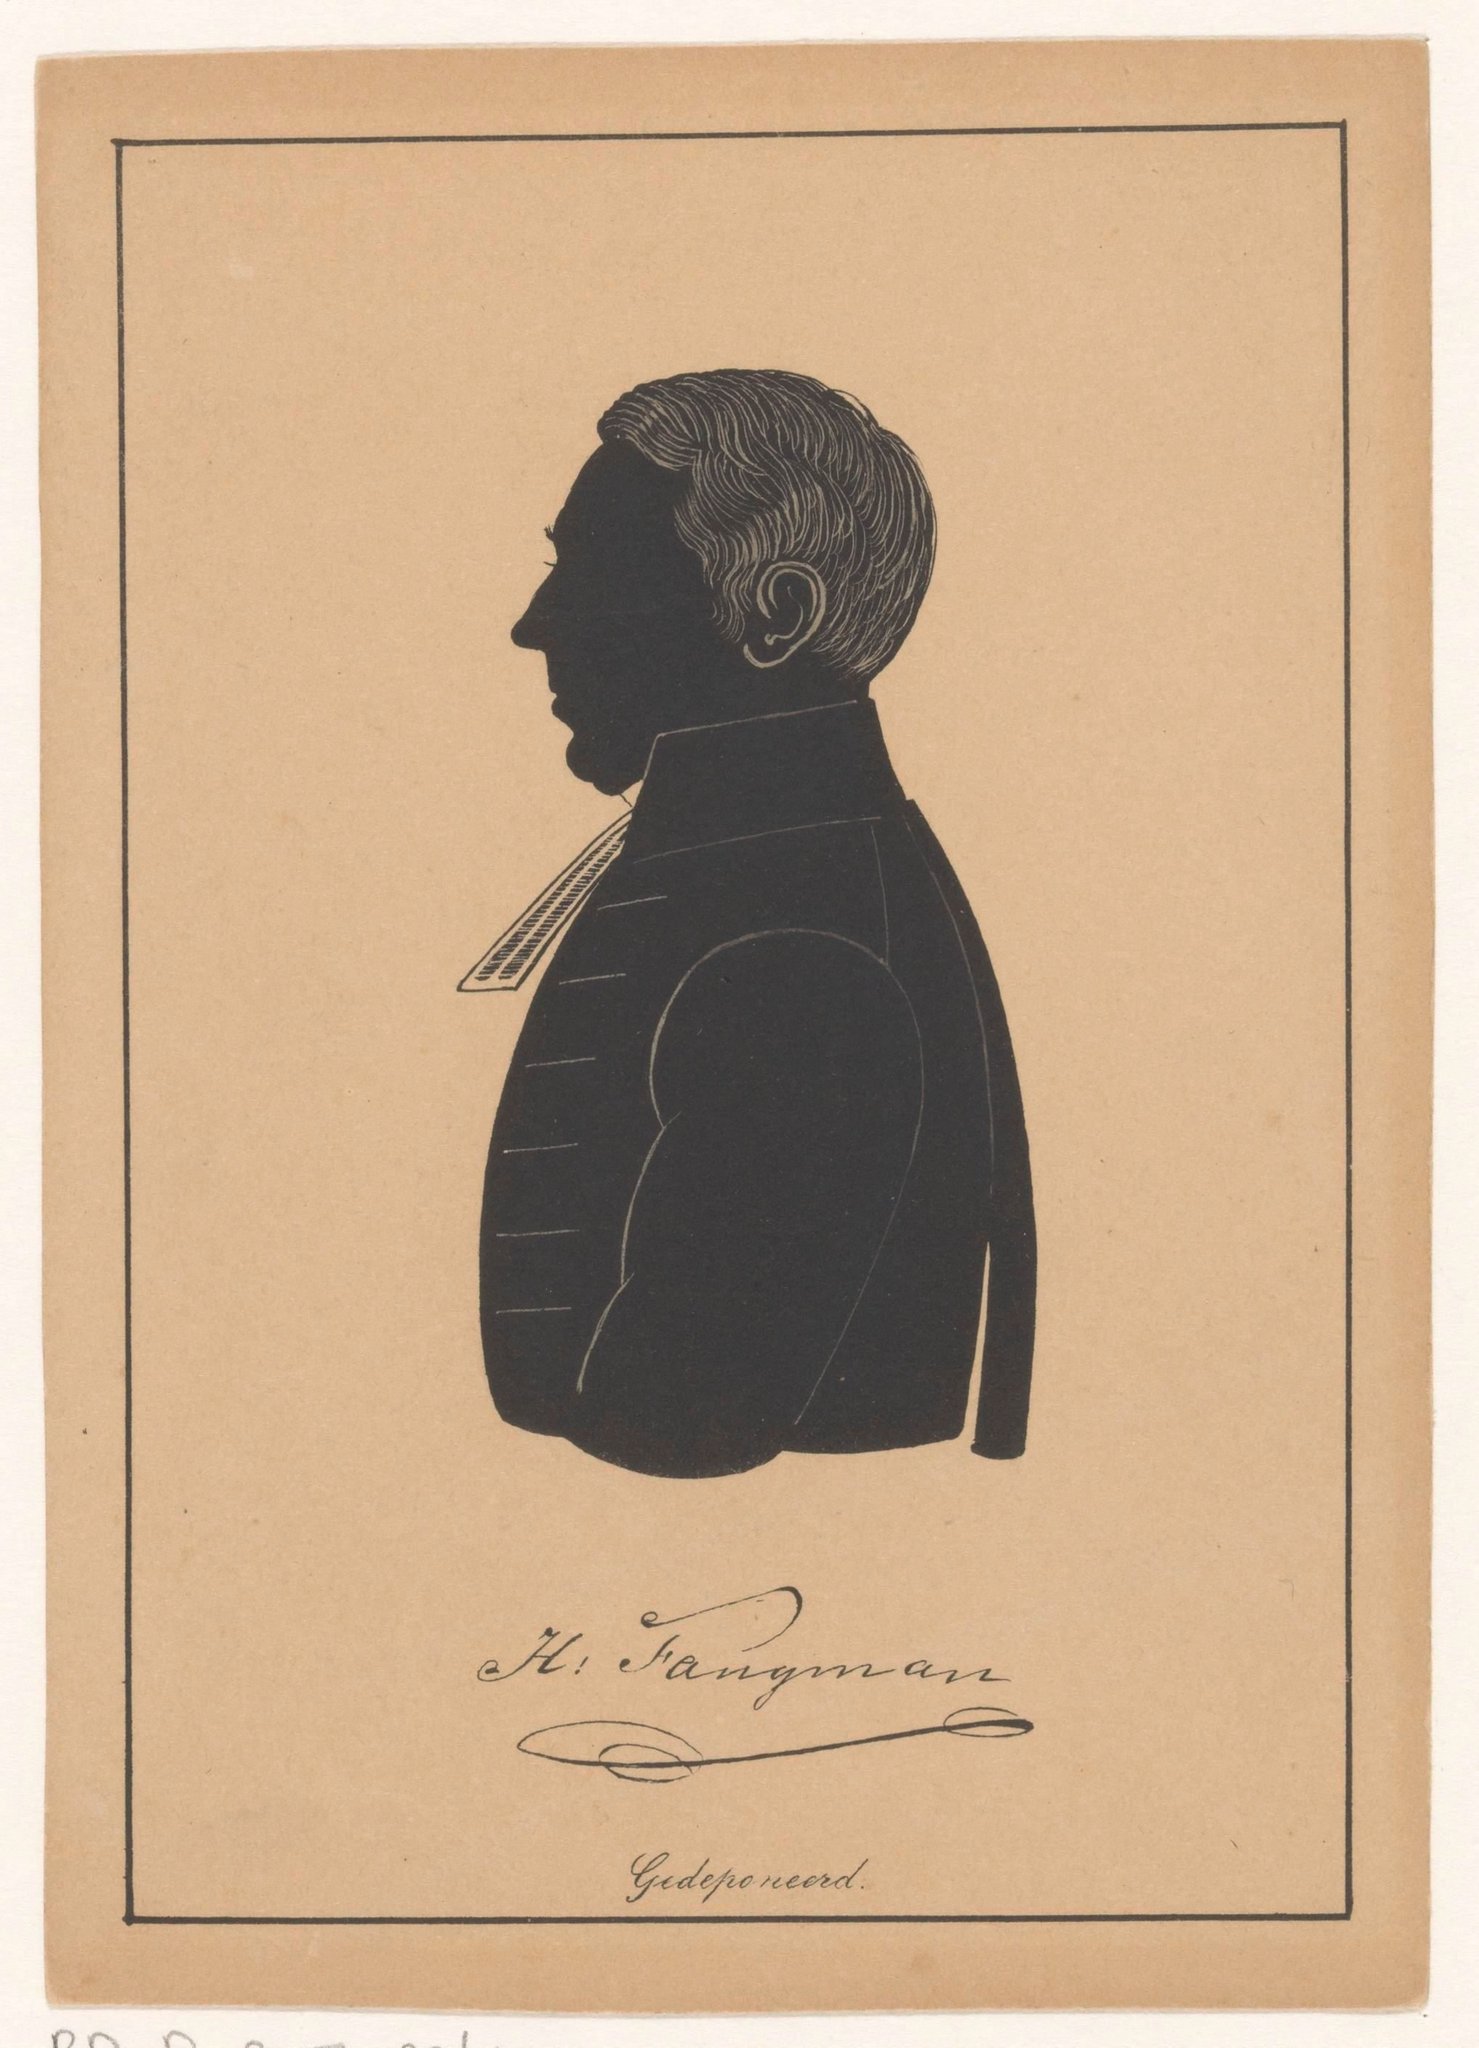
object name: print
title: Silhouetportret van Herman Fangman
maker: pieter barbiers (iv)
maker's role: painter, print maker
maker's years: 1798-1848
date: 1809-1848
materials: paper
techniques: hand coloring, lithograph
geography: netherlands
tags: hoorn (north holland), historical persons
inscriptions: collector's mark: Lugt 2228, : ‘Gedeponeerd.’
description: Onder het portret de signatuur van de geportretteerde.